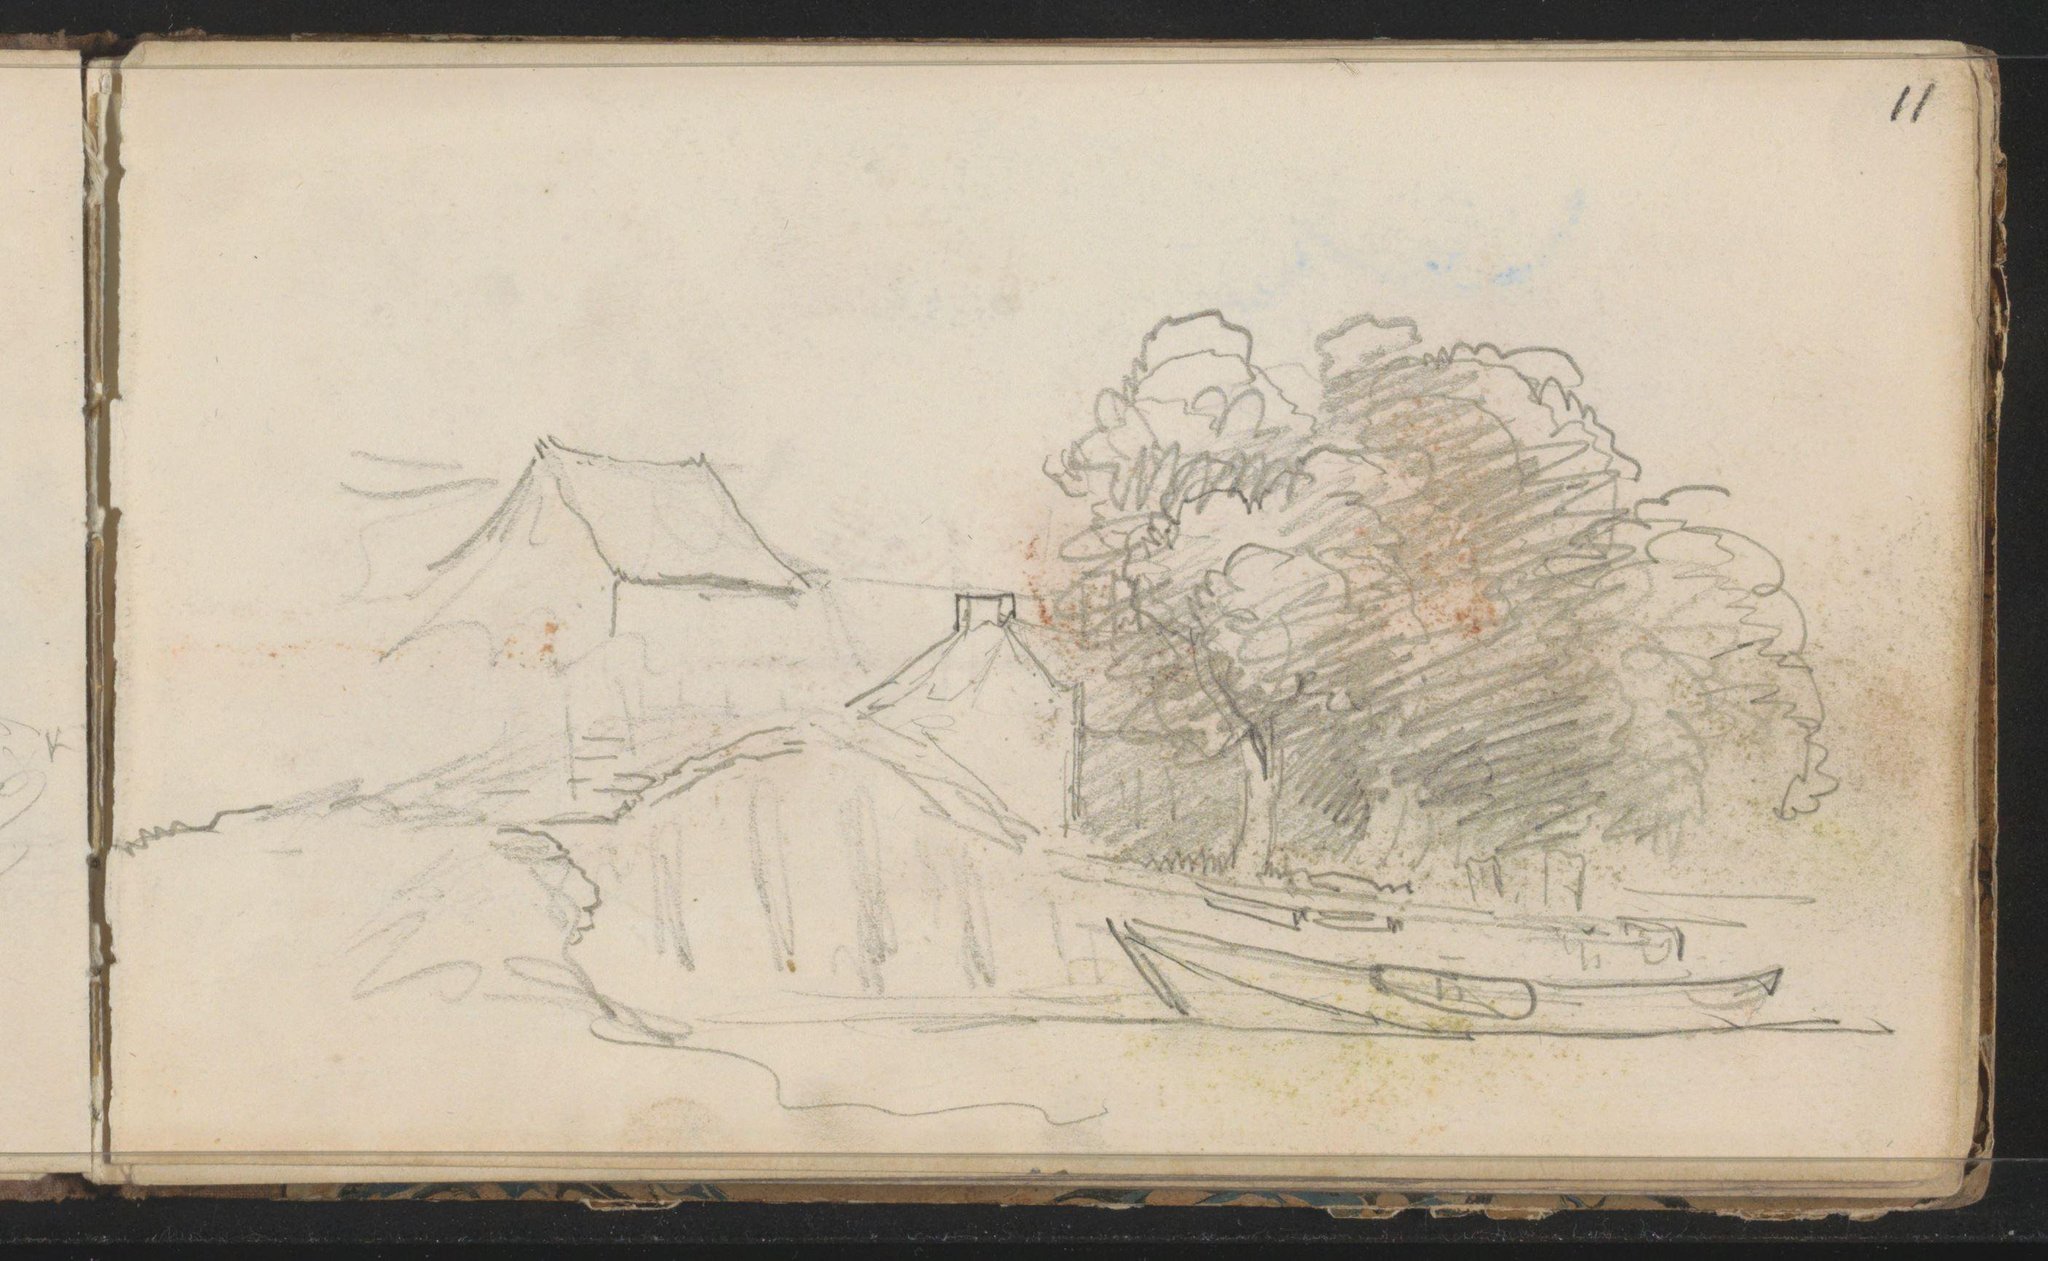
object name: sketchbook leaf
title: Brug over het water bij een dorp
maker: arnoldus johannes eymer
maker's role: draughtsman, print maker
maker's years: 1803-1863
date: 1803-1818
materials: paper, pencil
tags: city-view, and landscape with man-made constructions, rowing-boat, canoe, etc., bridge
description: Bladzijde 11 uit een schetsboek met 74 bladzijden.